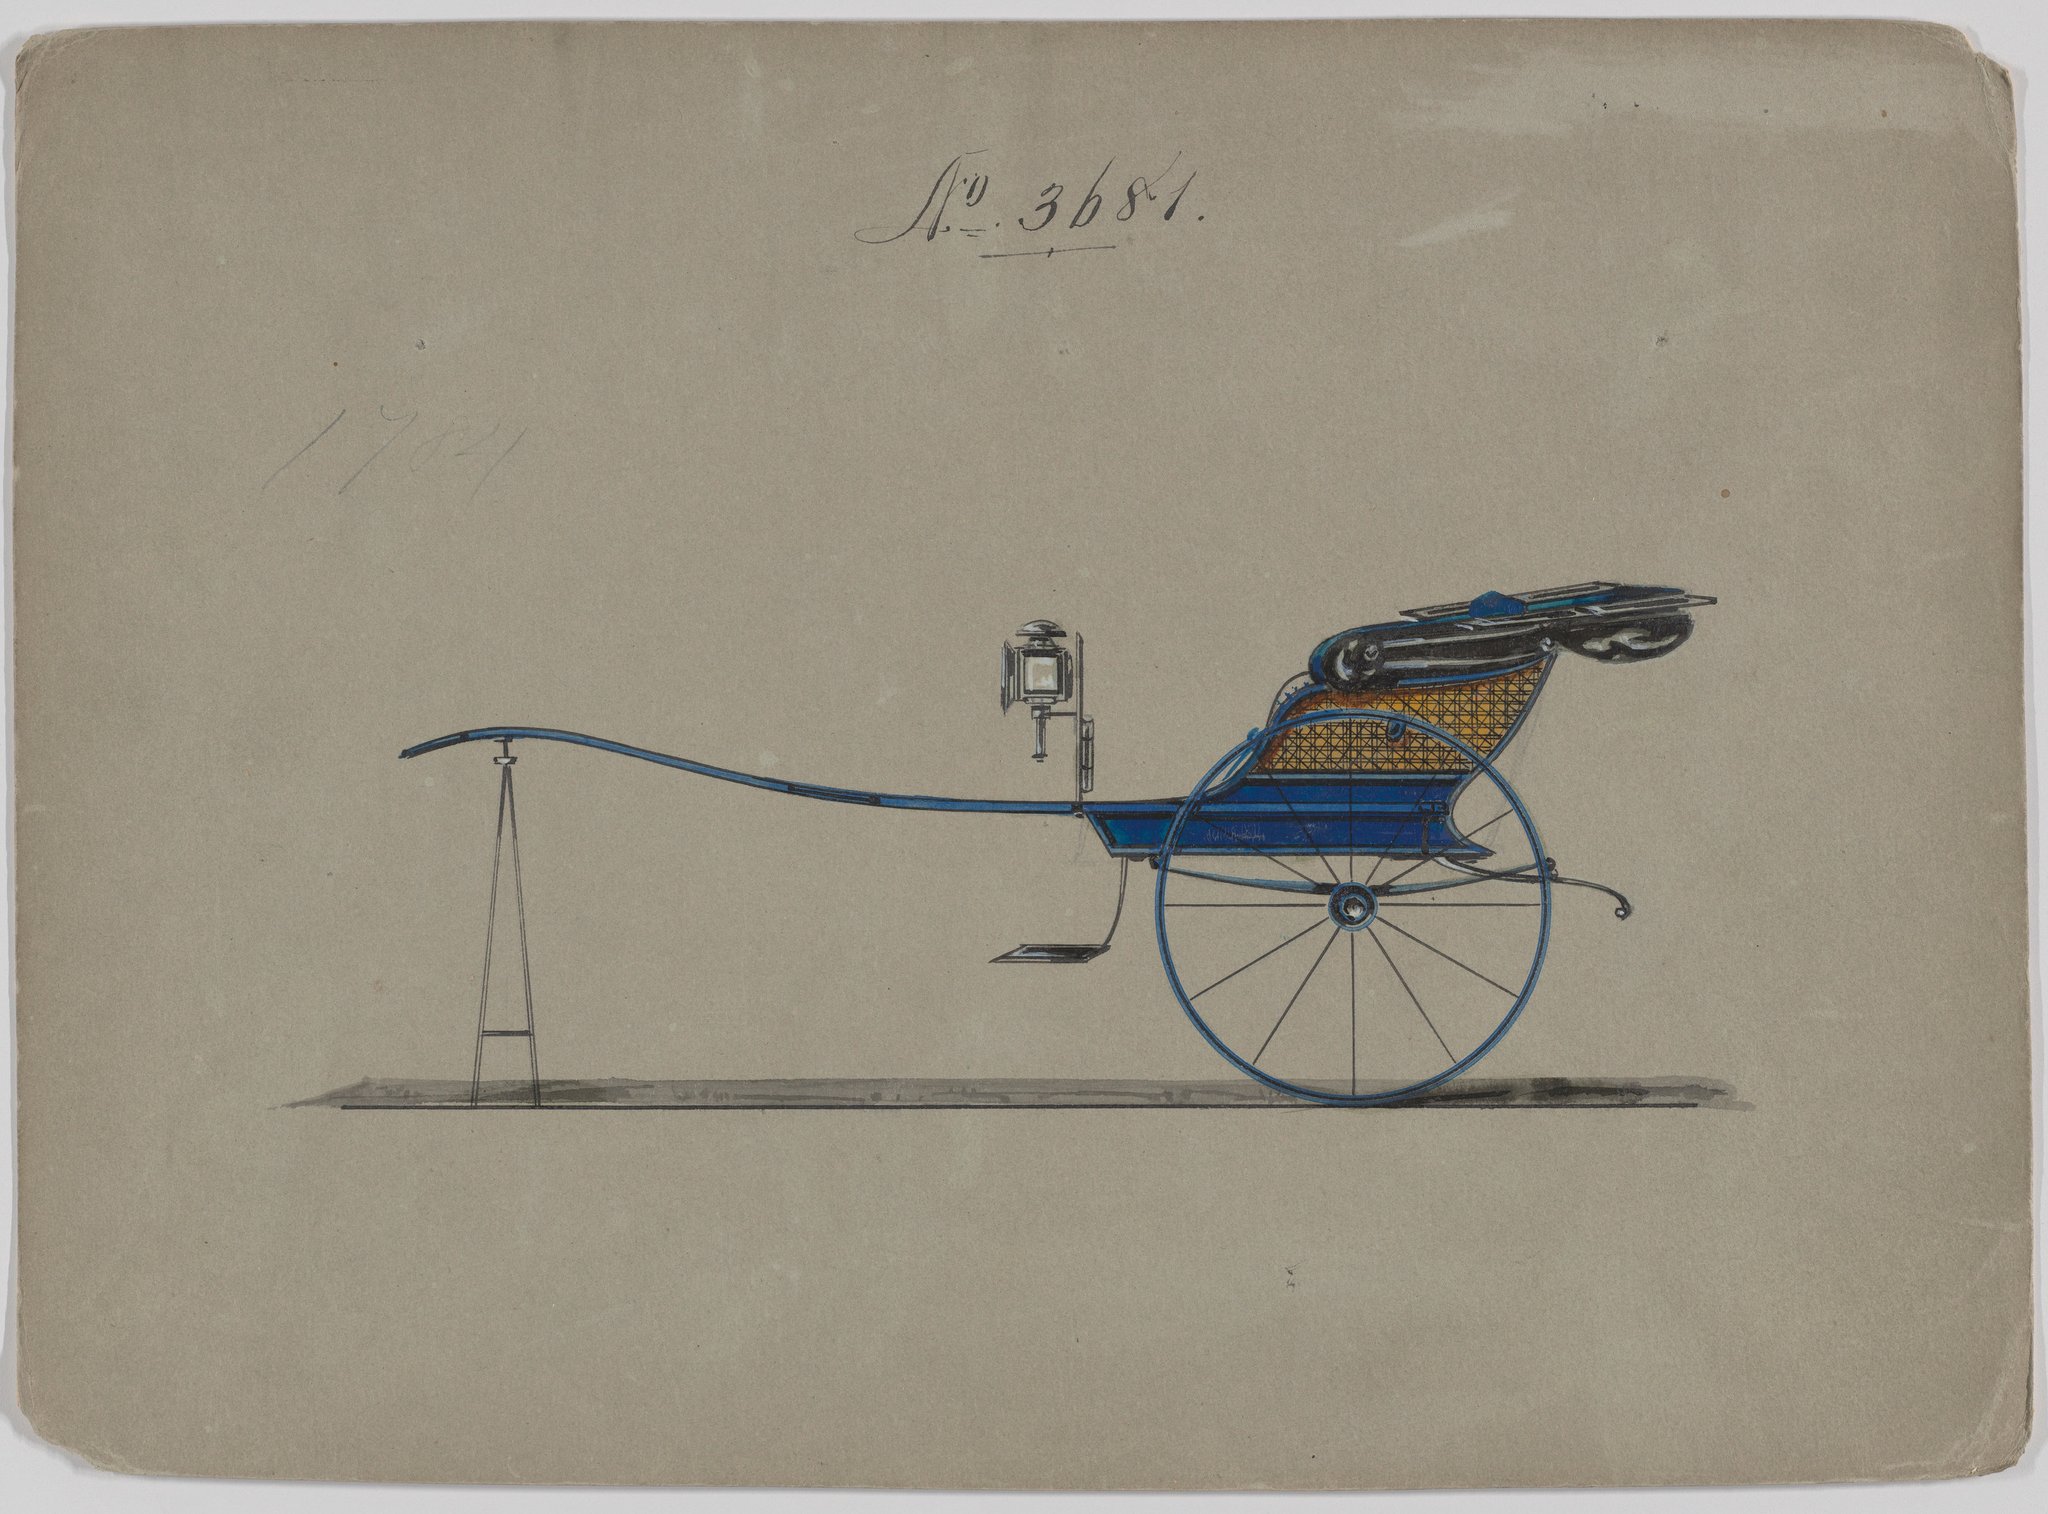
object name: drawing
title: Gig #3681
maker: brewster & co.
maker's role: manufacturer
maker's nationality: american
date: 1881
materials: gouache, gum arabic, ink, watercolor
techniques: pen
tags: carriages